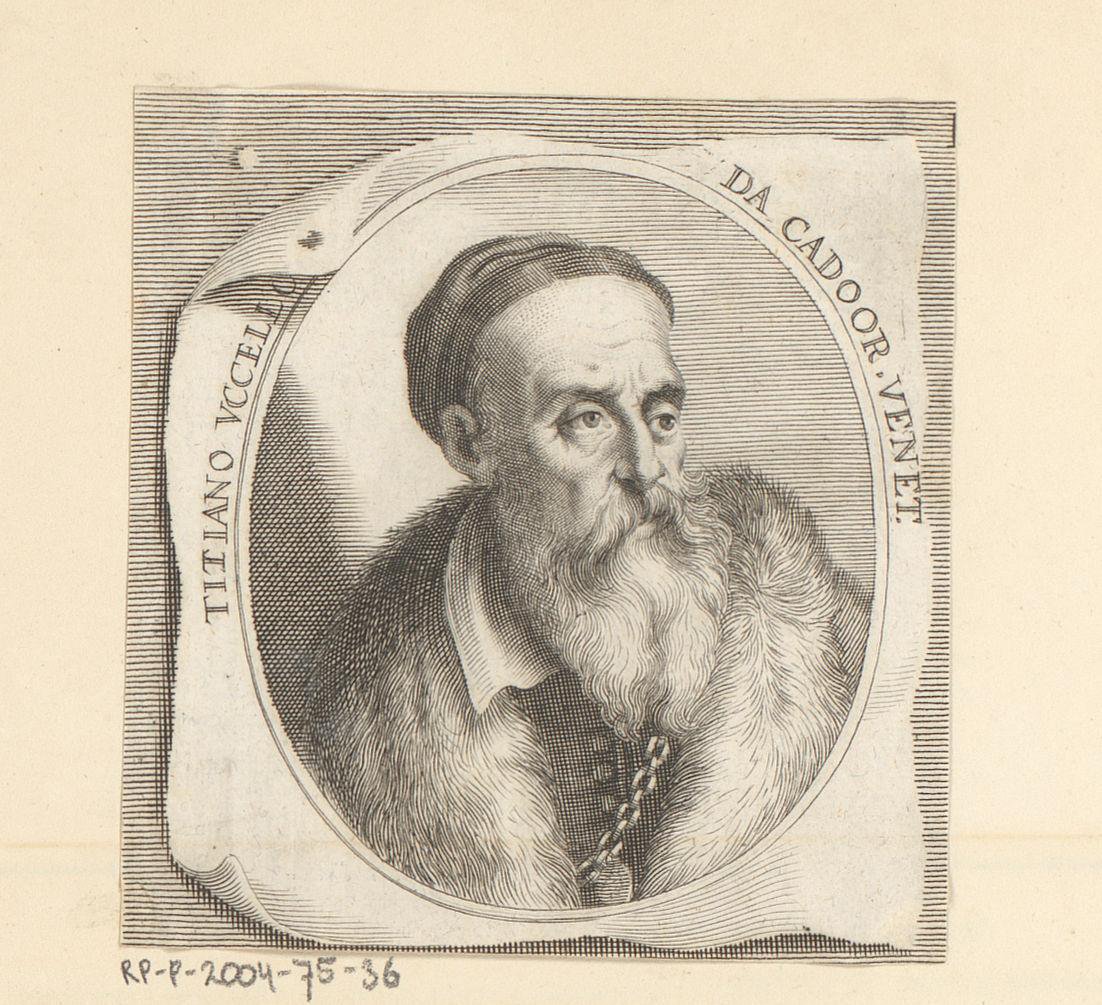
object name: album leaf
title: Portret van Titiaan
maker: philipp kilian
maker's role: print maker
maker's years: 1628-1693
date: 1768-1775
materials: paper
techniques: engraving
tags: venice, draughtsman, titiaan, historical persons, portrait, self-portrait of painter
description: Andere staat van de prent gebruikt in: Sandrart, Joachim von. Teutsche Academie der Bau- Bildhauer- und Maler-Kunst: worinn die Regeln und Lehrsätze dieser Künste gegeben. 14 dln. Neurenberg: erven Johann Andreas Endter, [1774], dl. 7, p. R. De samensteller heeft deze prent in het album geplakt als illustratie bij: Pilkington, Matthew en Johann Heinrich Füssli. A dictionary of painters, from the revival of the art to the present period. 4 dln. Londen: John Crowder, 1805, dl. 4, p. 600.